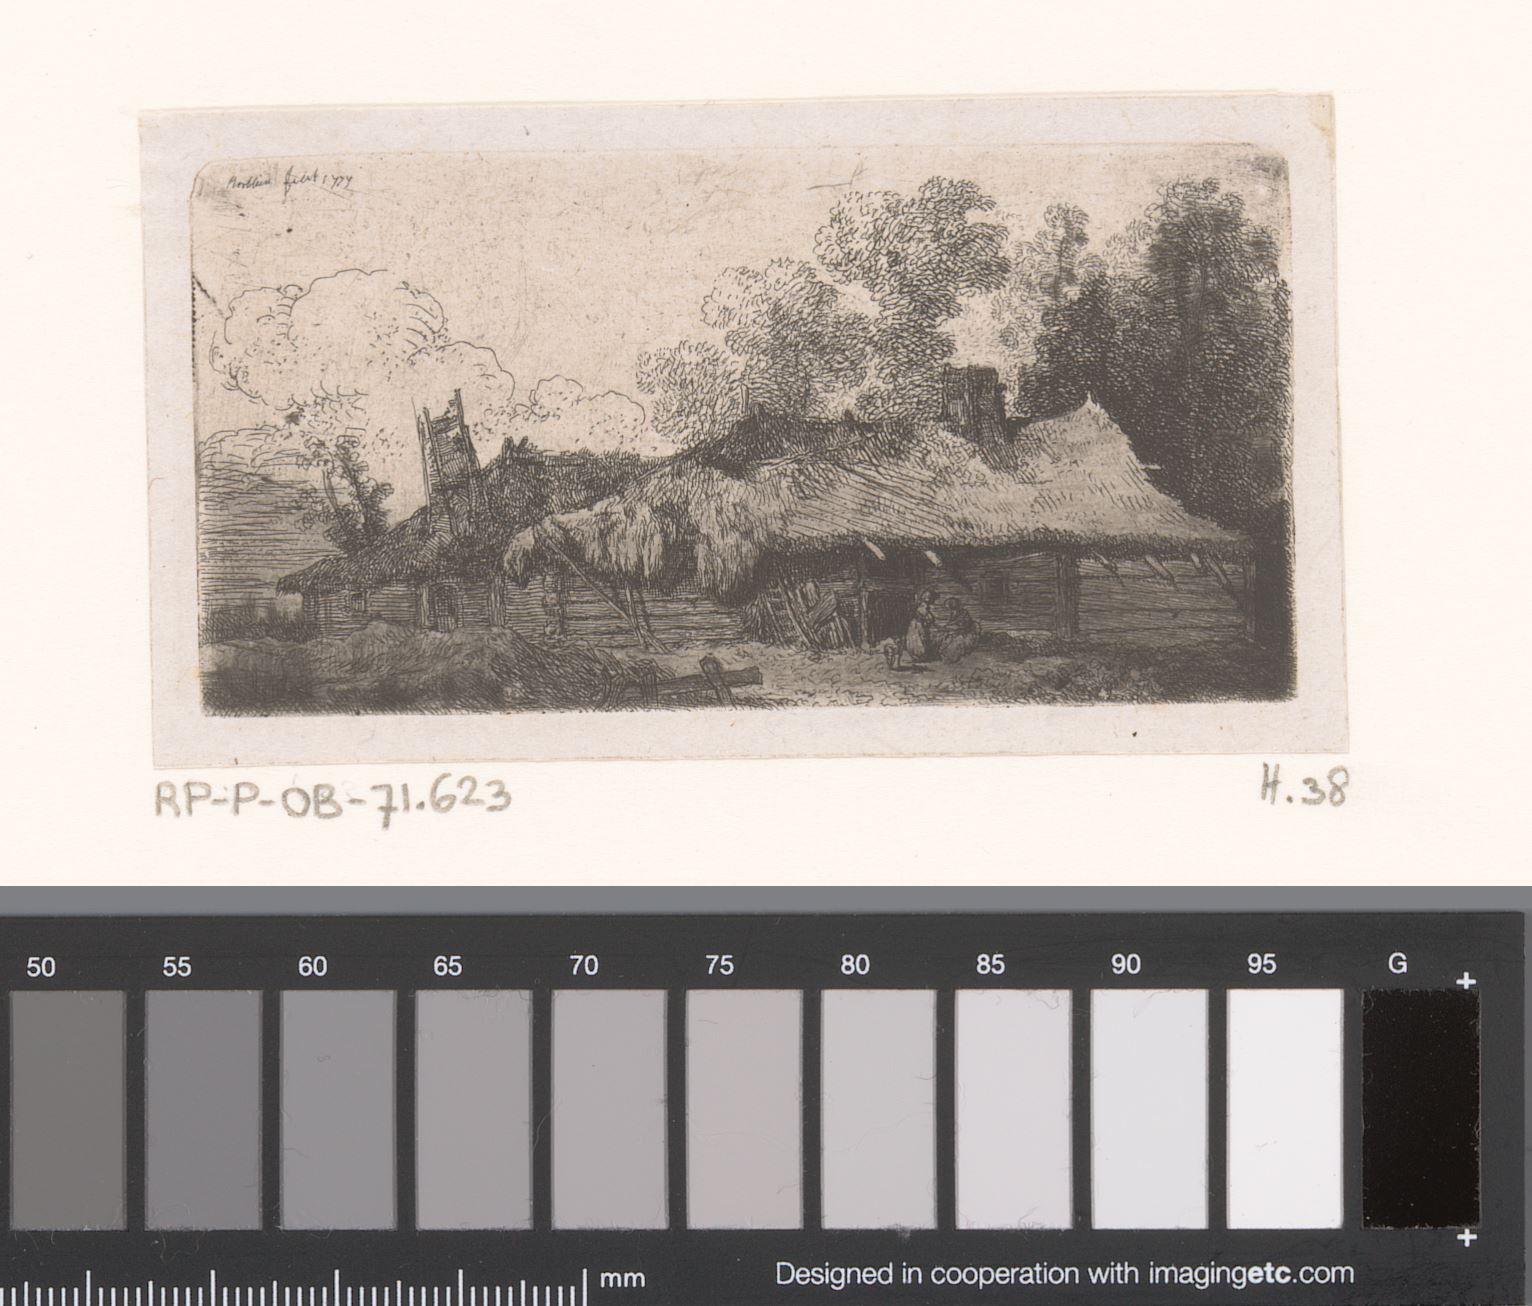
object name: print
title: Boerenerf met figuren en hond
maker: jean pierre norblin de la gourdaine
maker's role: print maker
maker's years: 1745-1830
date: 1777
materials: paper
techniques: etching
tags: farm or solitary house in landscape, dog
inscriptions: collector's mark: Lugt 2228